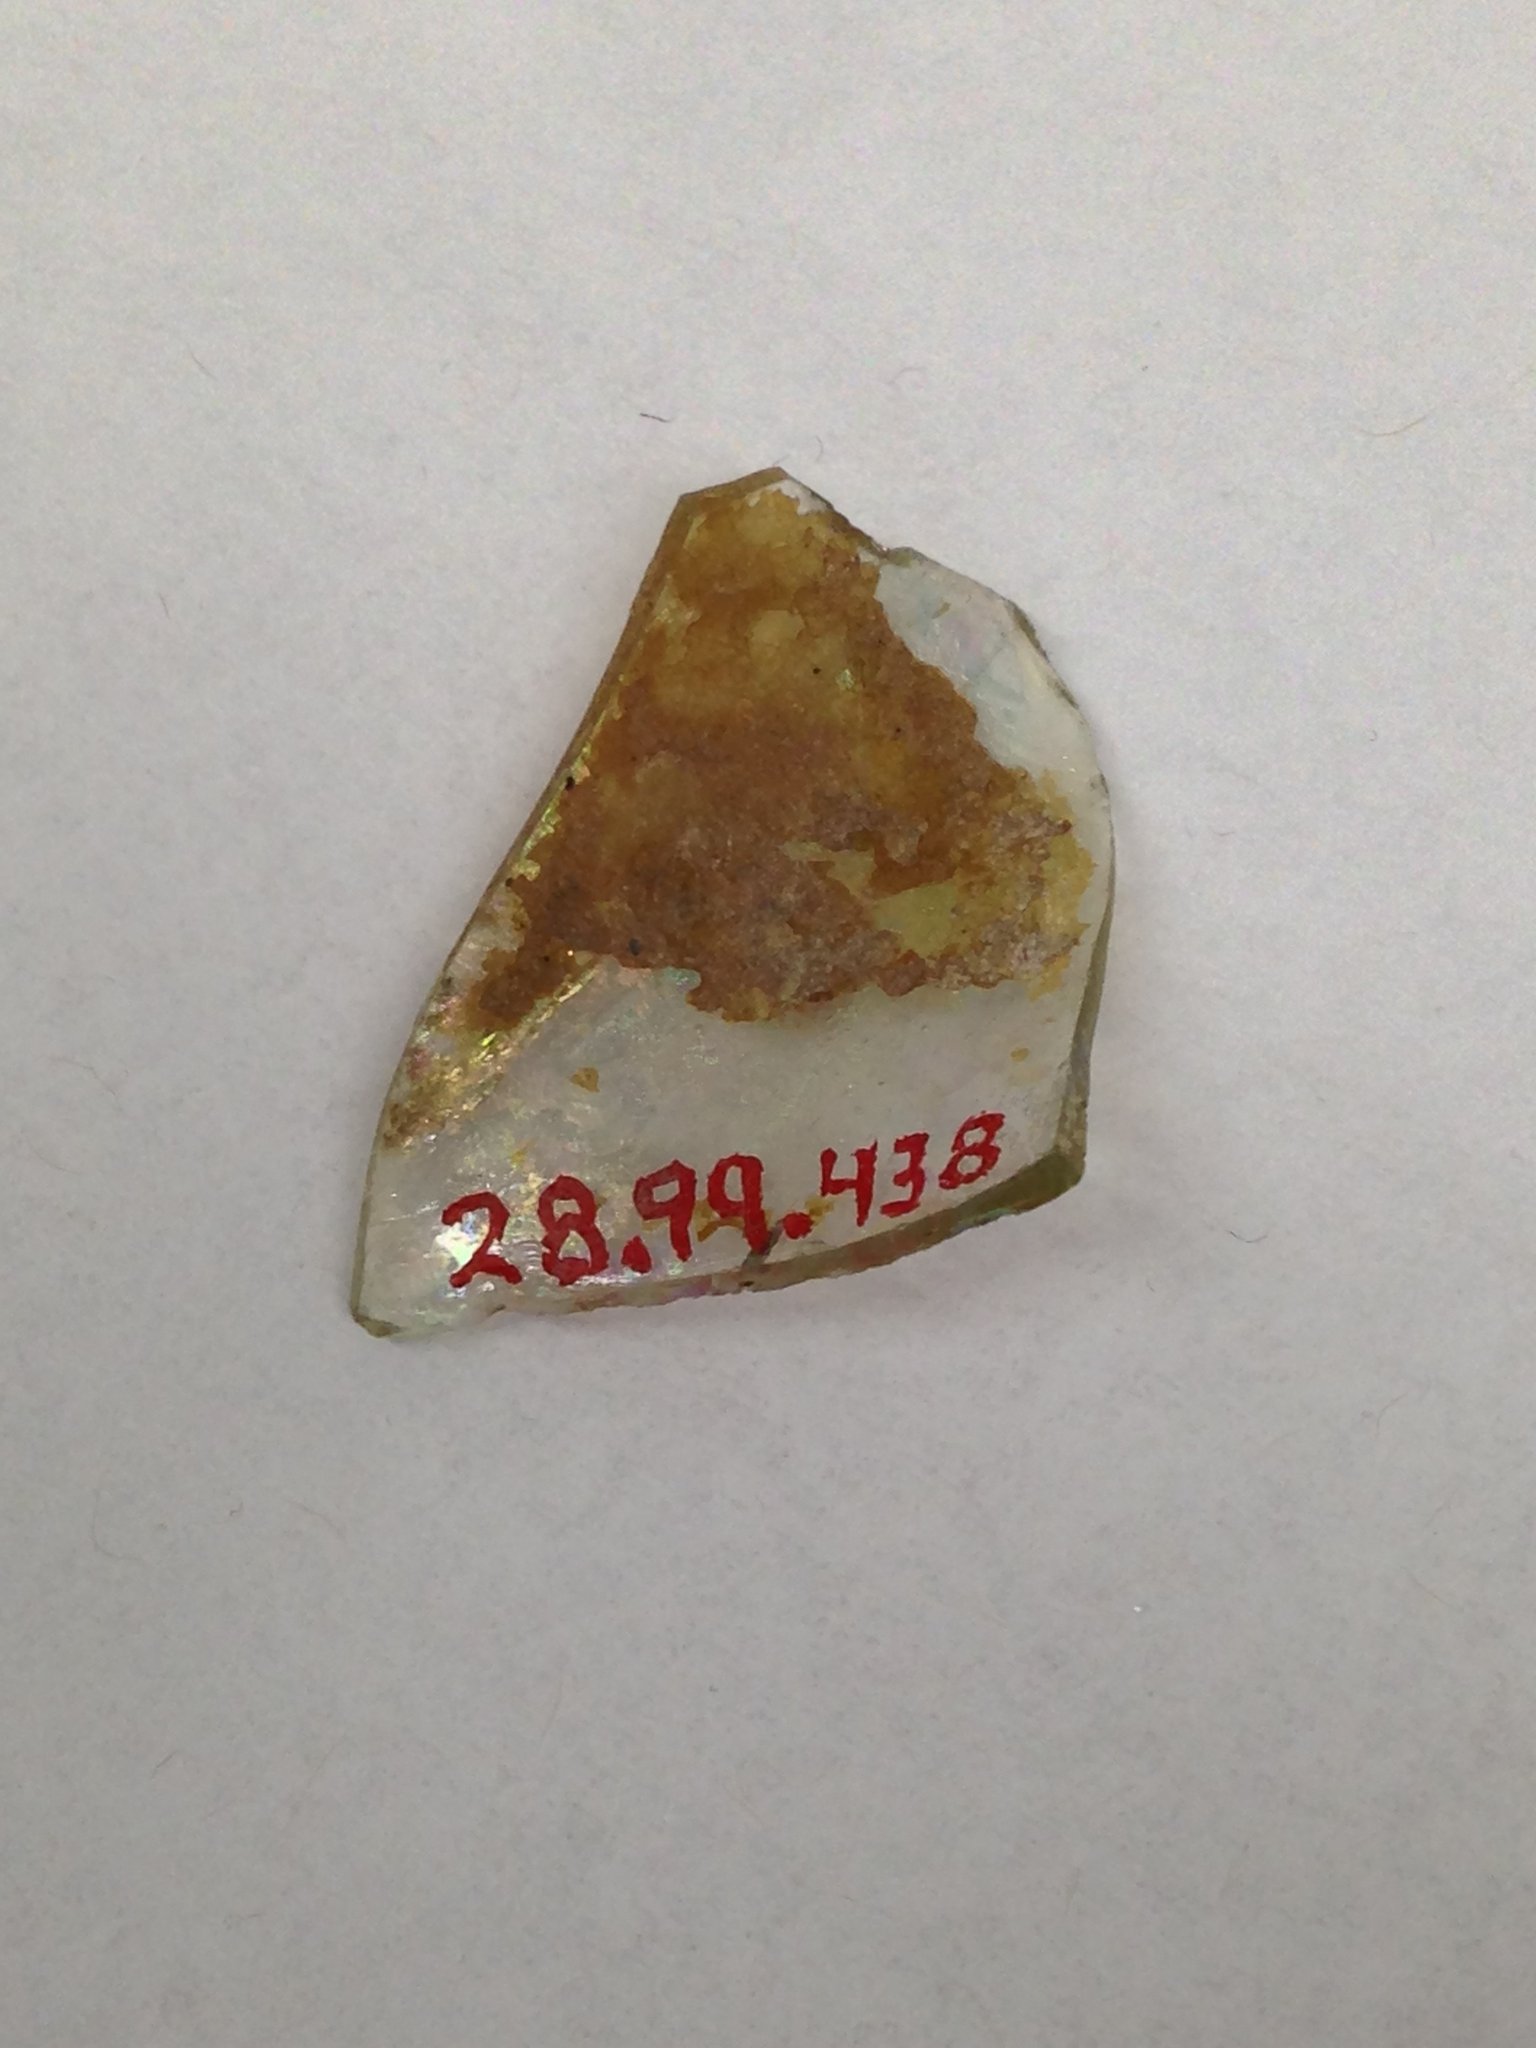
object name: fragment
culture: european or middle eastern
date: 1150-1250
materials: ceramic, glass